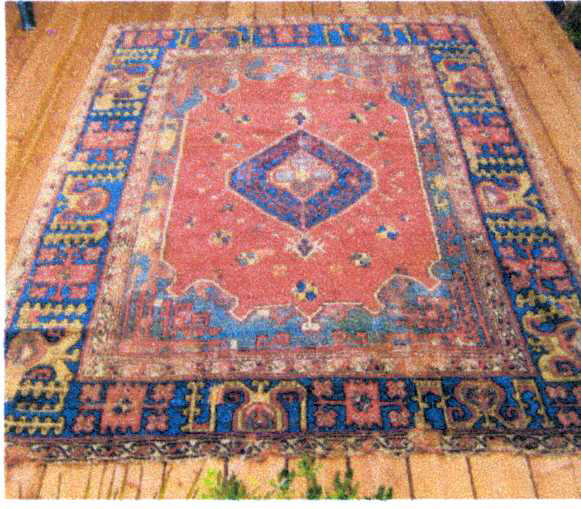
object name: carpet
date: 1601-1800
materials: wool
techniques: pile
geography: turkey